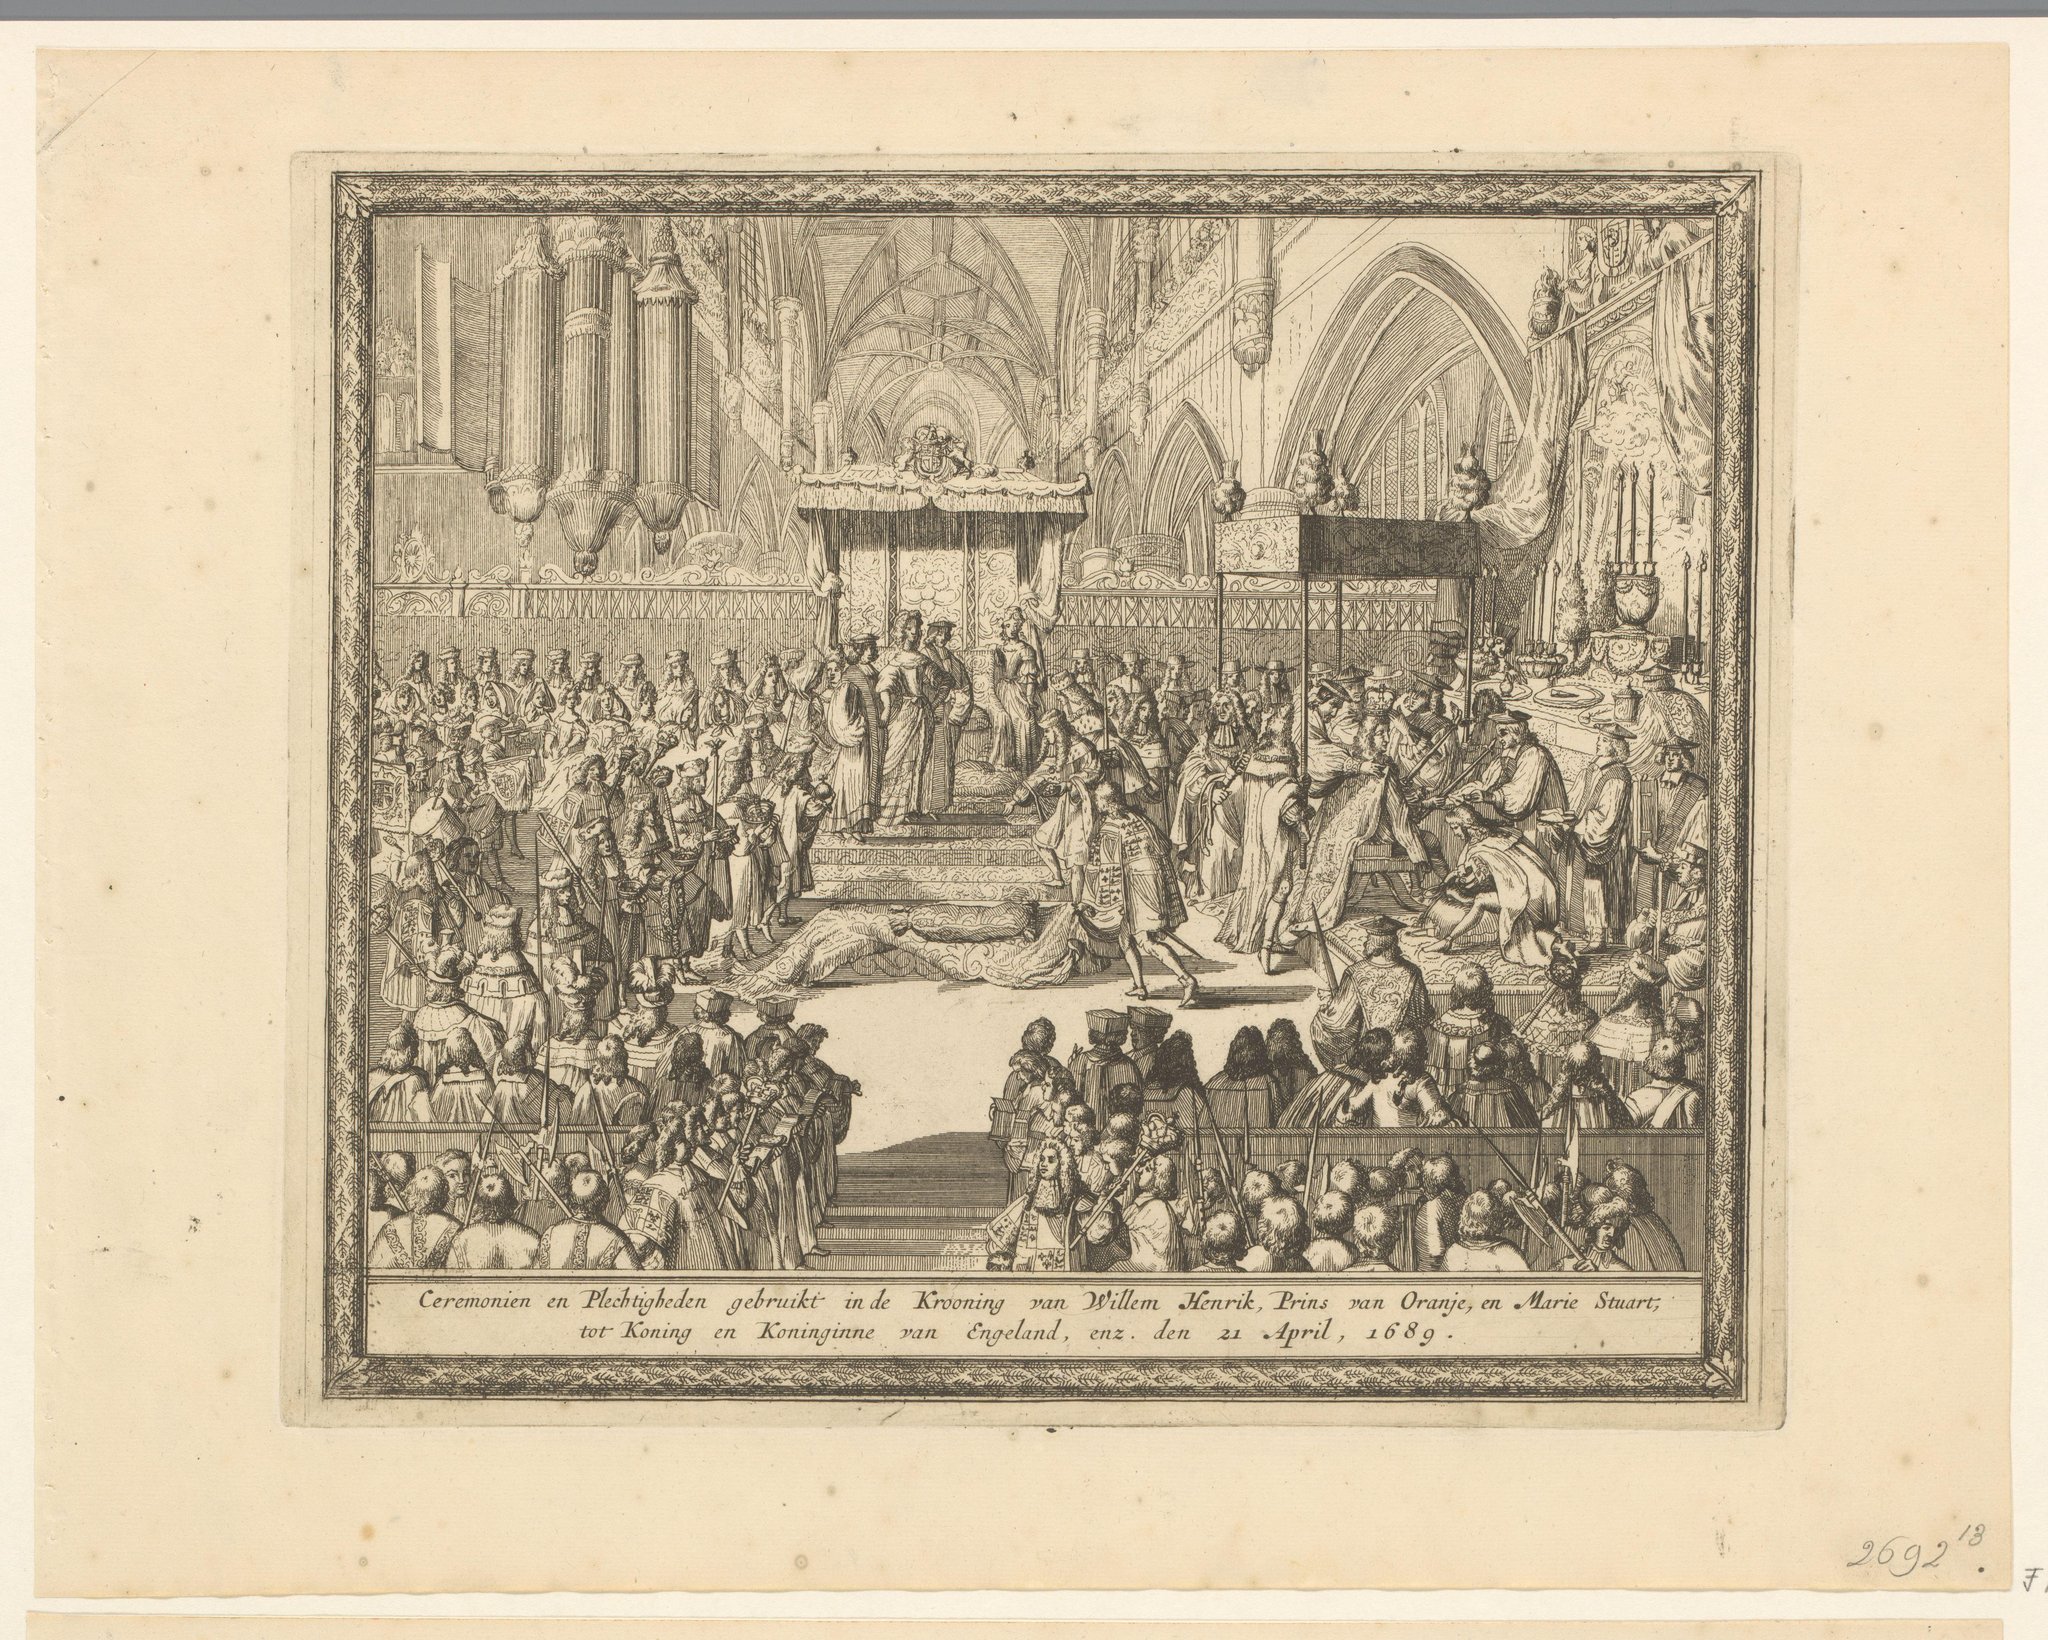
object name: print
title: Cremonien en Plechtighedfen gebruikt in de Krooning van Willem Henrik, Prins van Oranje, en Marie Stuart, tot Koning en Koninginne van Engeland, enz. den 21 April, 1689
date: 1691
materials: paper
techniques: etching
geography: northern netherlands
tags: the hague, william iii (prince of orange and king of england, scotland, and ireland), london, maria ii stuart (koningin van engeland, schotland en ierland), during the coronation, westminster abbey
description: De kroning van Willem III en Mary tot koning en koningin van Engeland in de Westminster Abbey, 21 april 1689. Plaat 13 in een serie van 20 platen over de Glorious Revolution in Engeland in de jaren 1688-1691.